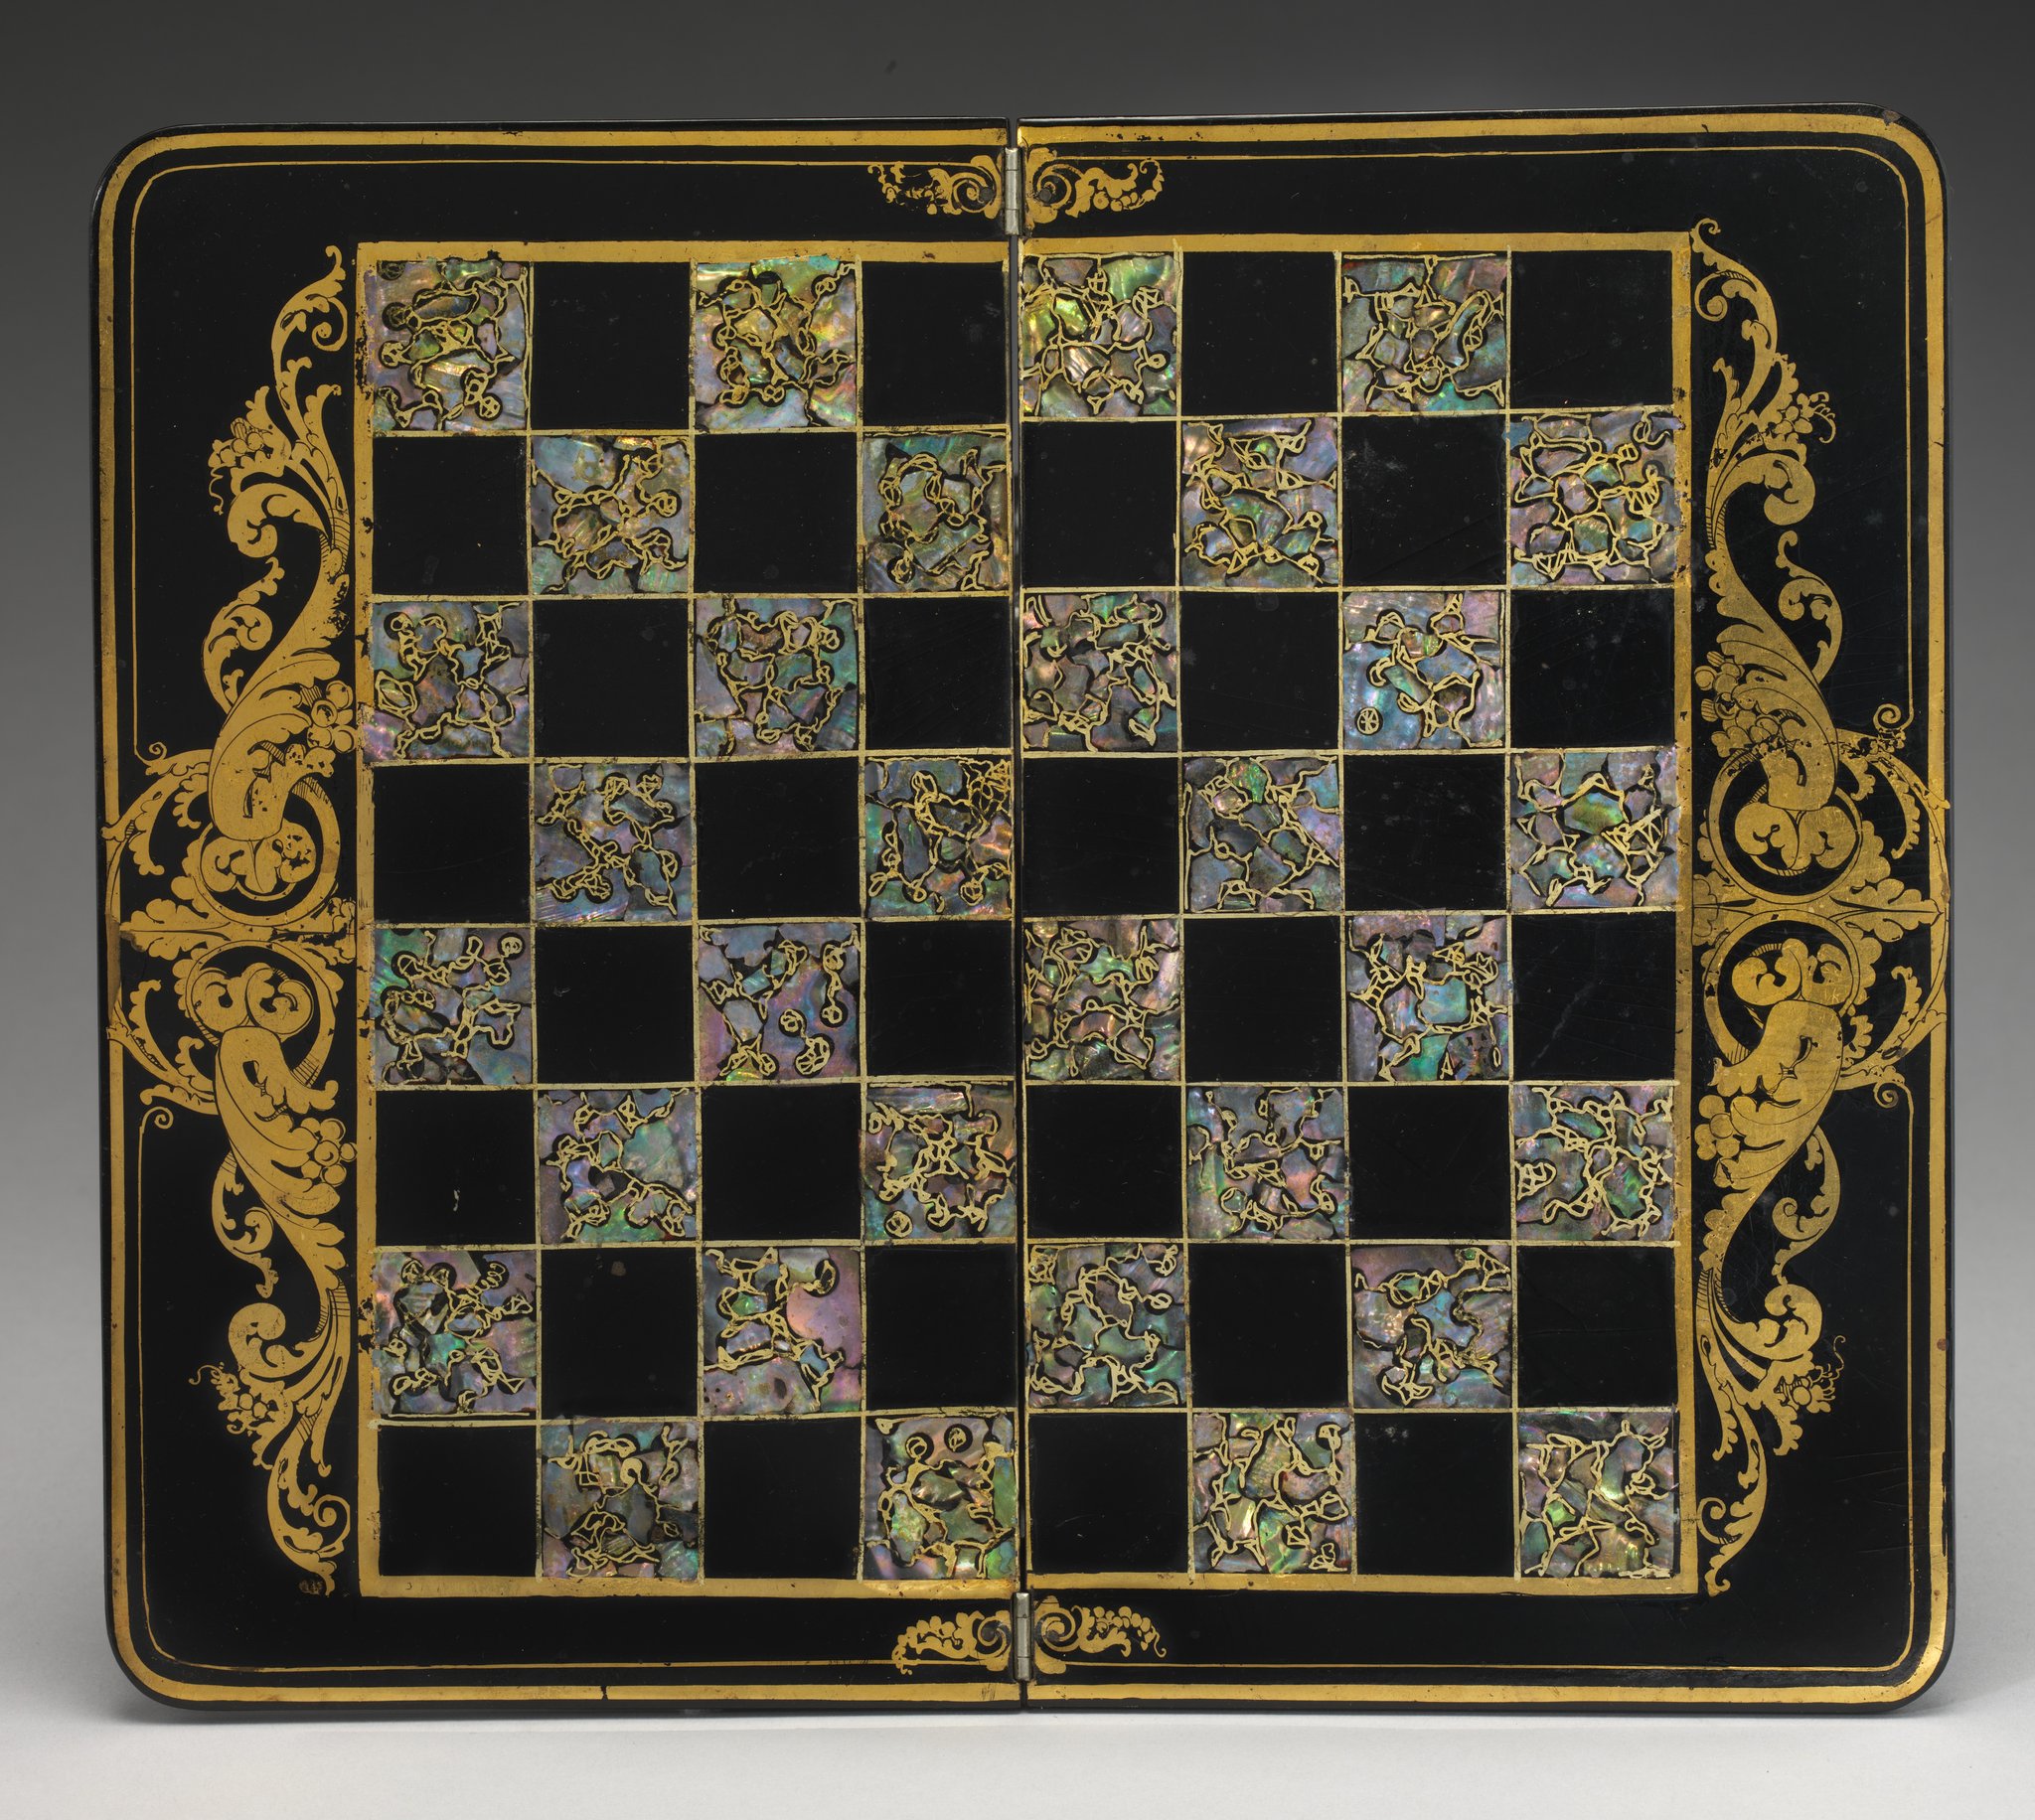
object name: chessboard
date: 1801-1900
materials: wood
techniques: lacquer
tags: chess